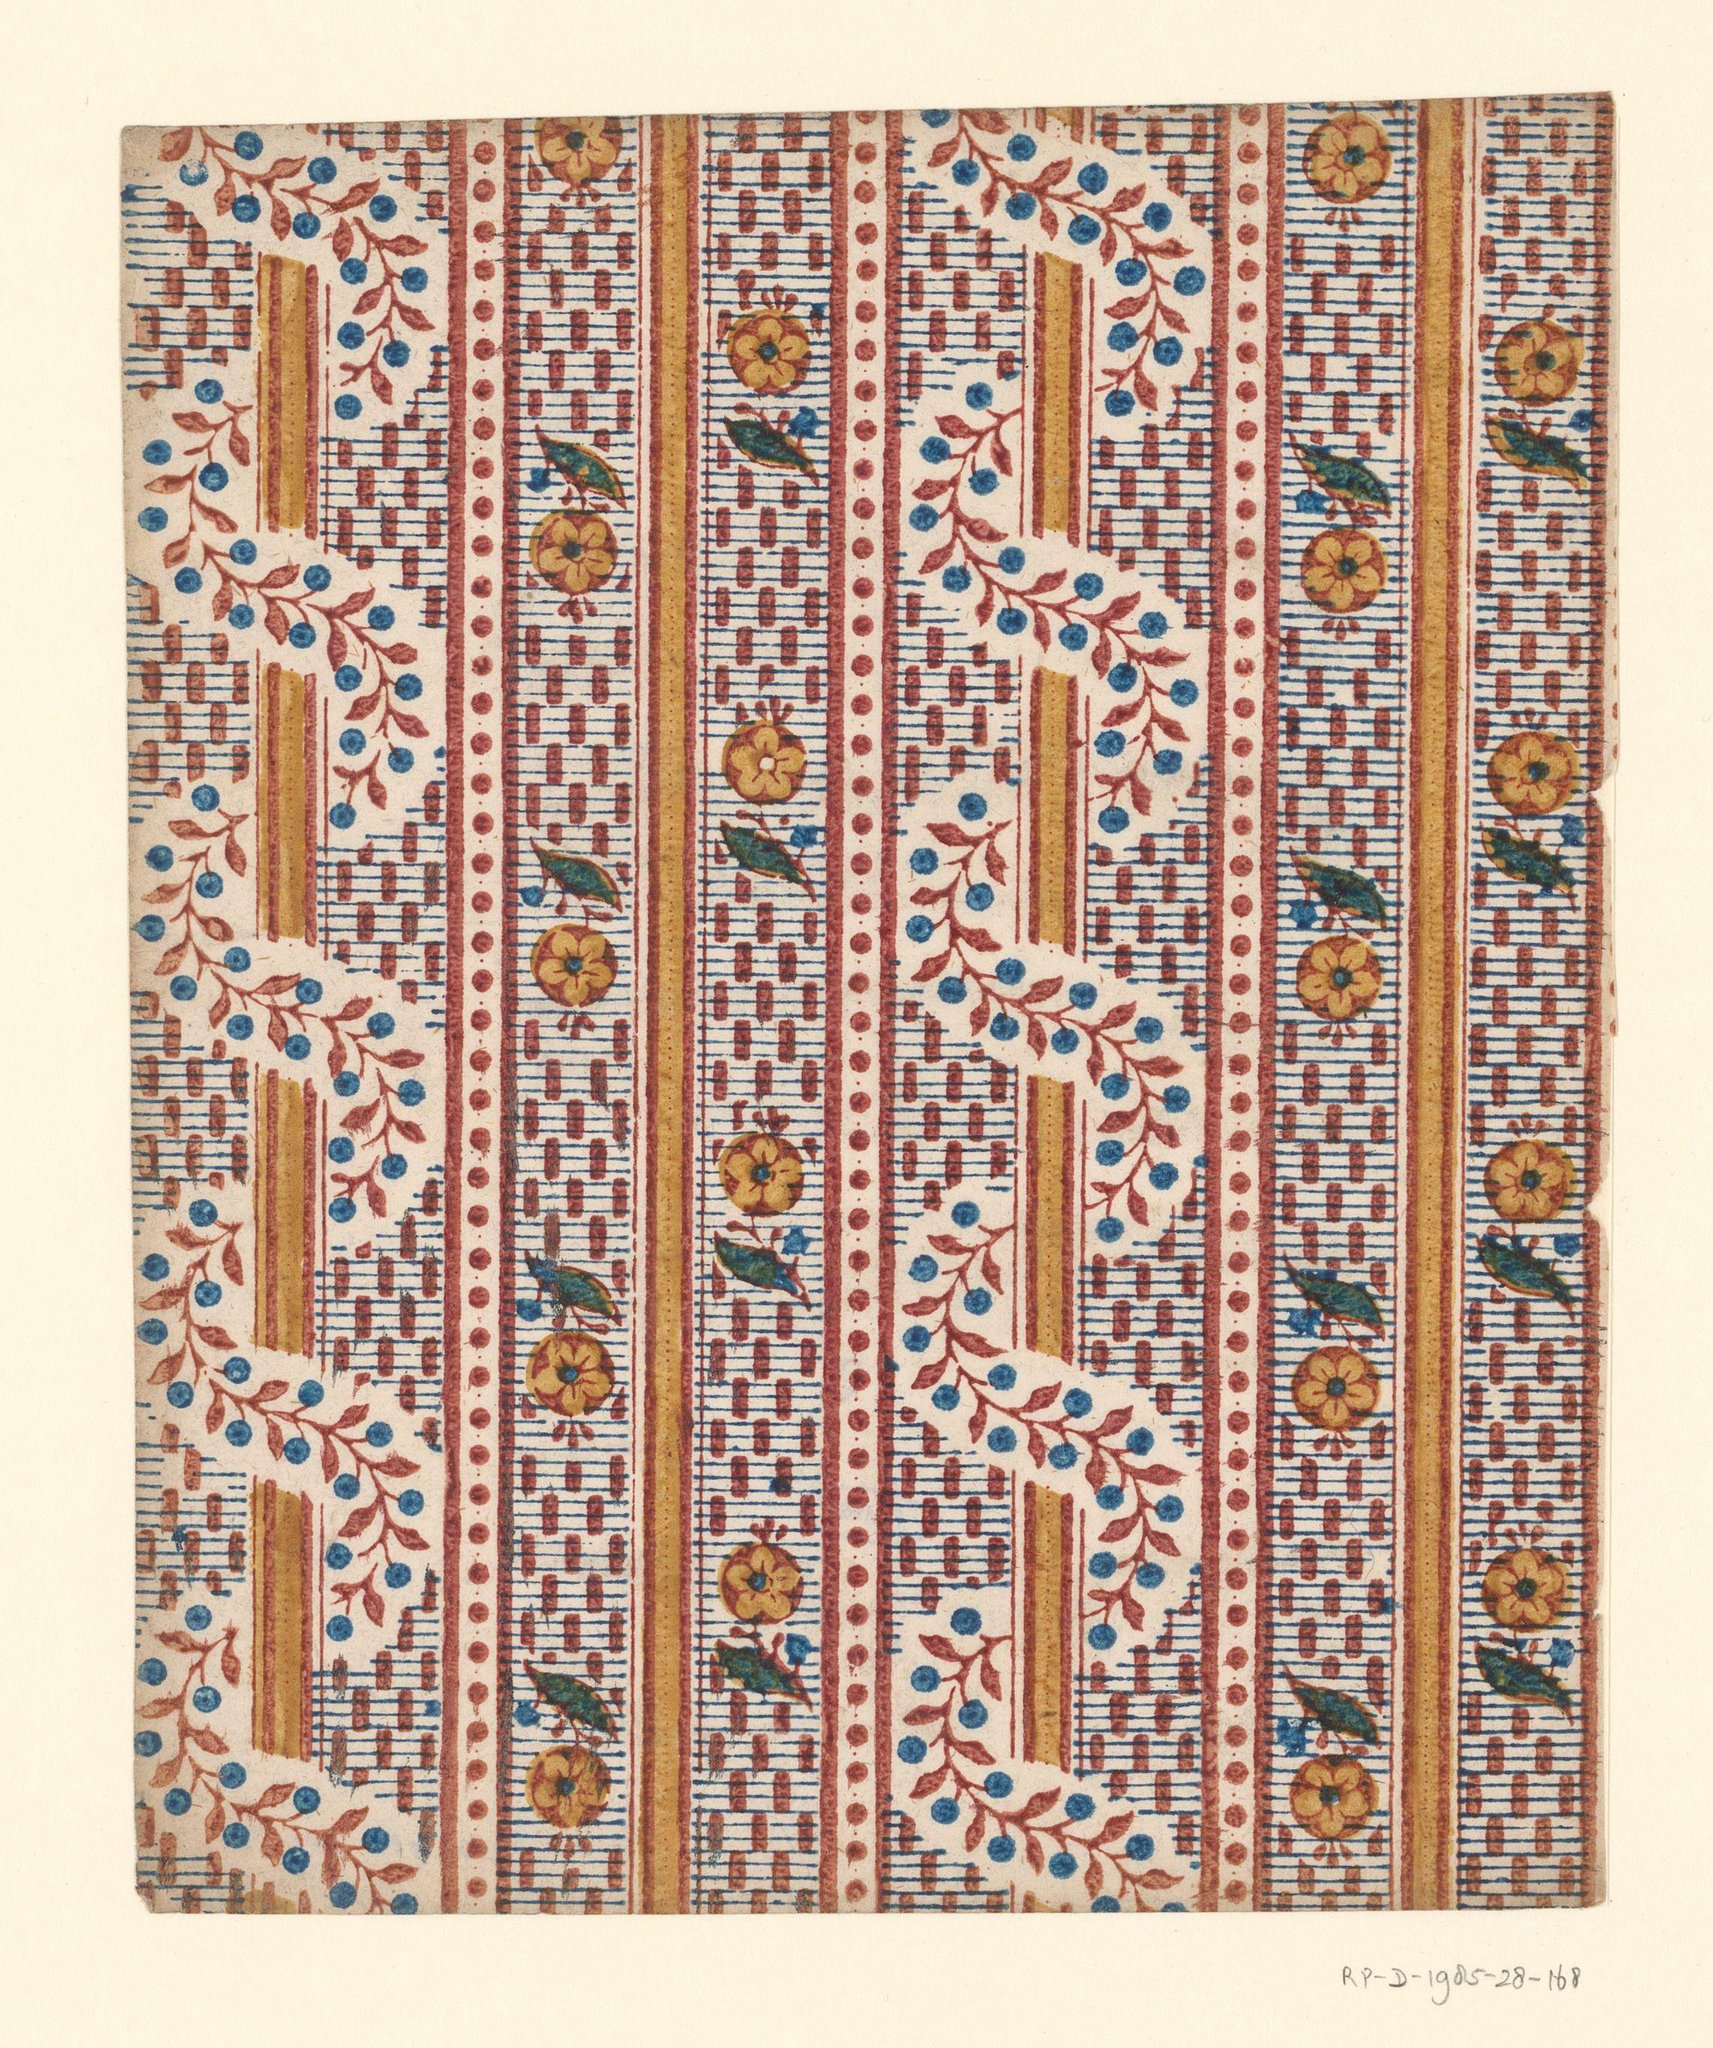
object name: wrapper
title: Blad met banenpatroon van staaf omwonden door rank met vruchtjes alternerend met bloemen met onderbroken lijnenfond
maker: Anonymous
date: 1750-1900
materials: paper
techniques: printing block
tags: ornament derived from plant forms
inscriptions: collector's mark: Lugt 2228, collector's mark: Lugt 2760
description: Blad met banenpatroon van staaf omwonden door rank met vruchtjes alternerend met bloemen met onderbroken lijnenfond. Helft van een omslag.